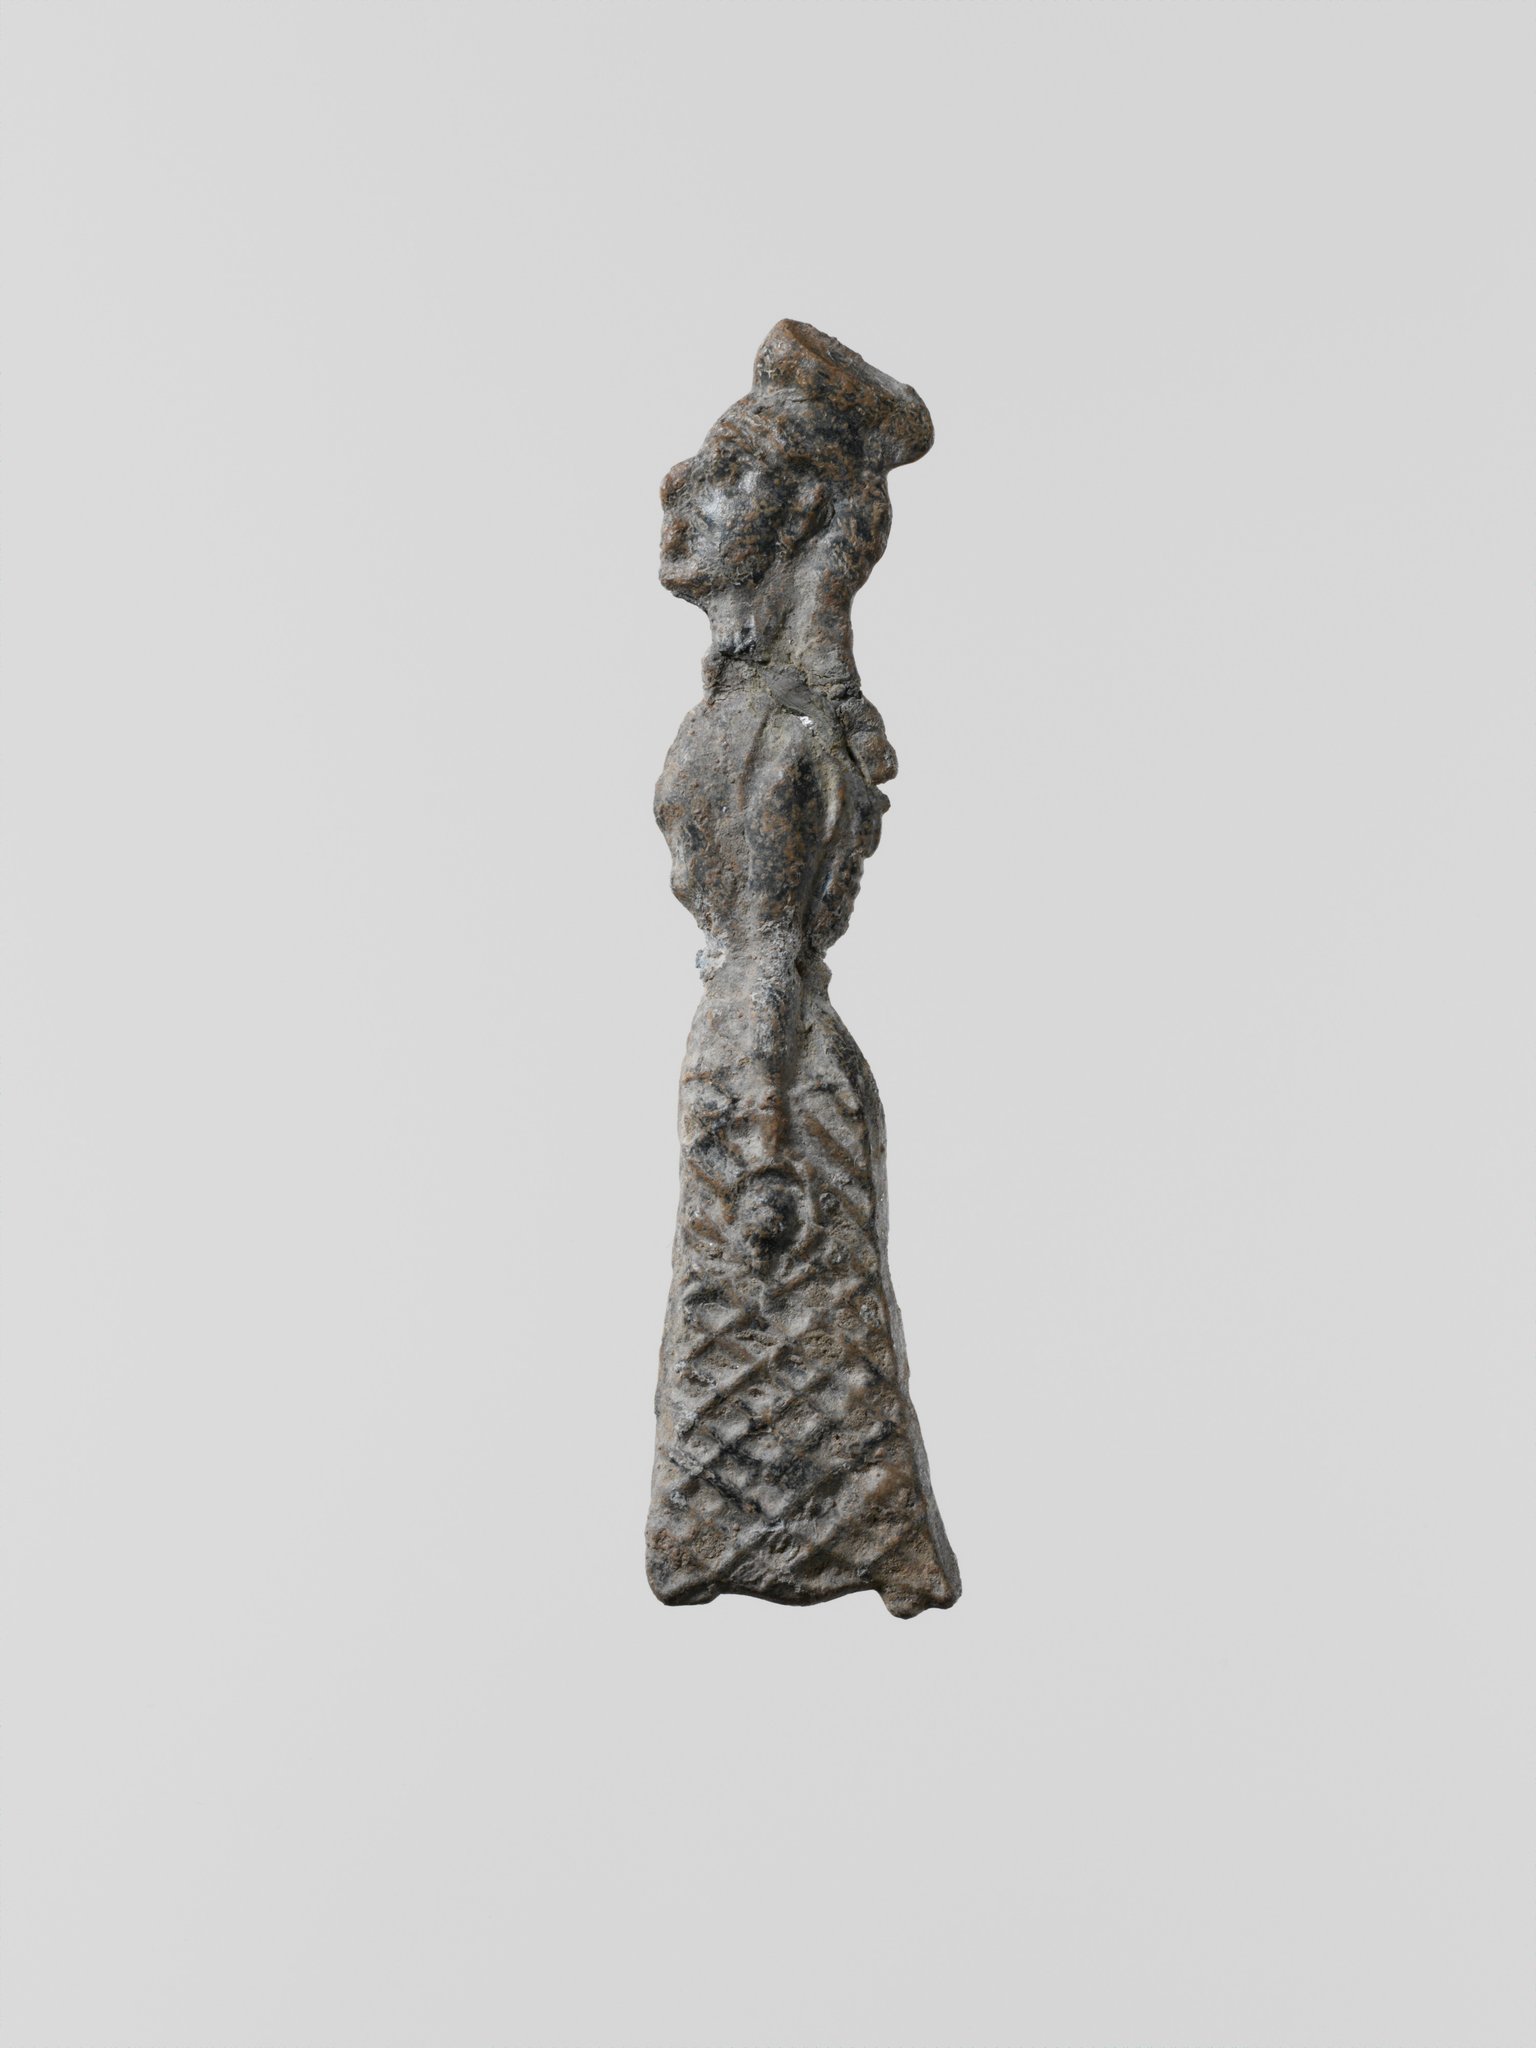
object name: statuette of a woman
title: Lead figure of a woman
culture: greek, laconian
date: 634-568 BCE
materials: lead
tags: women